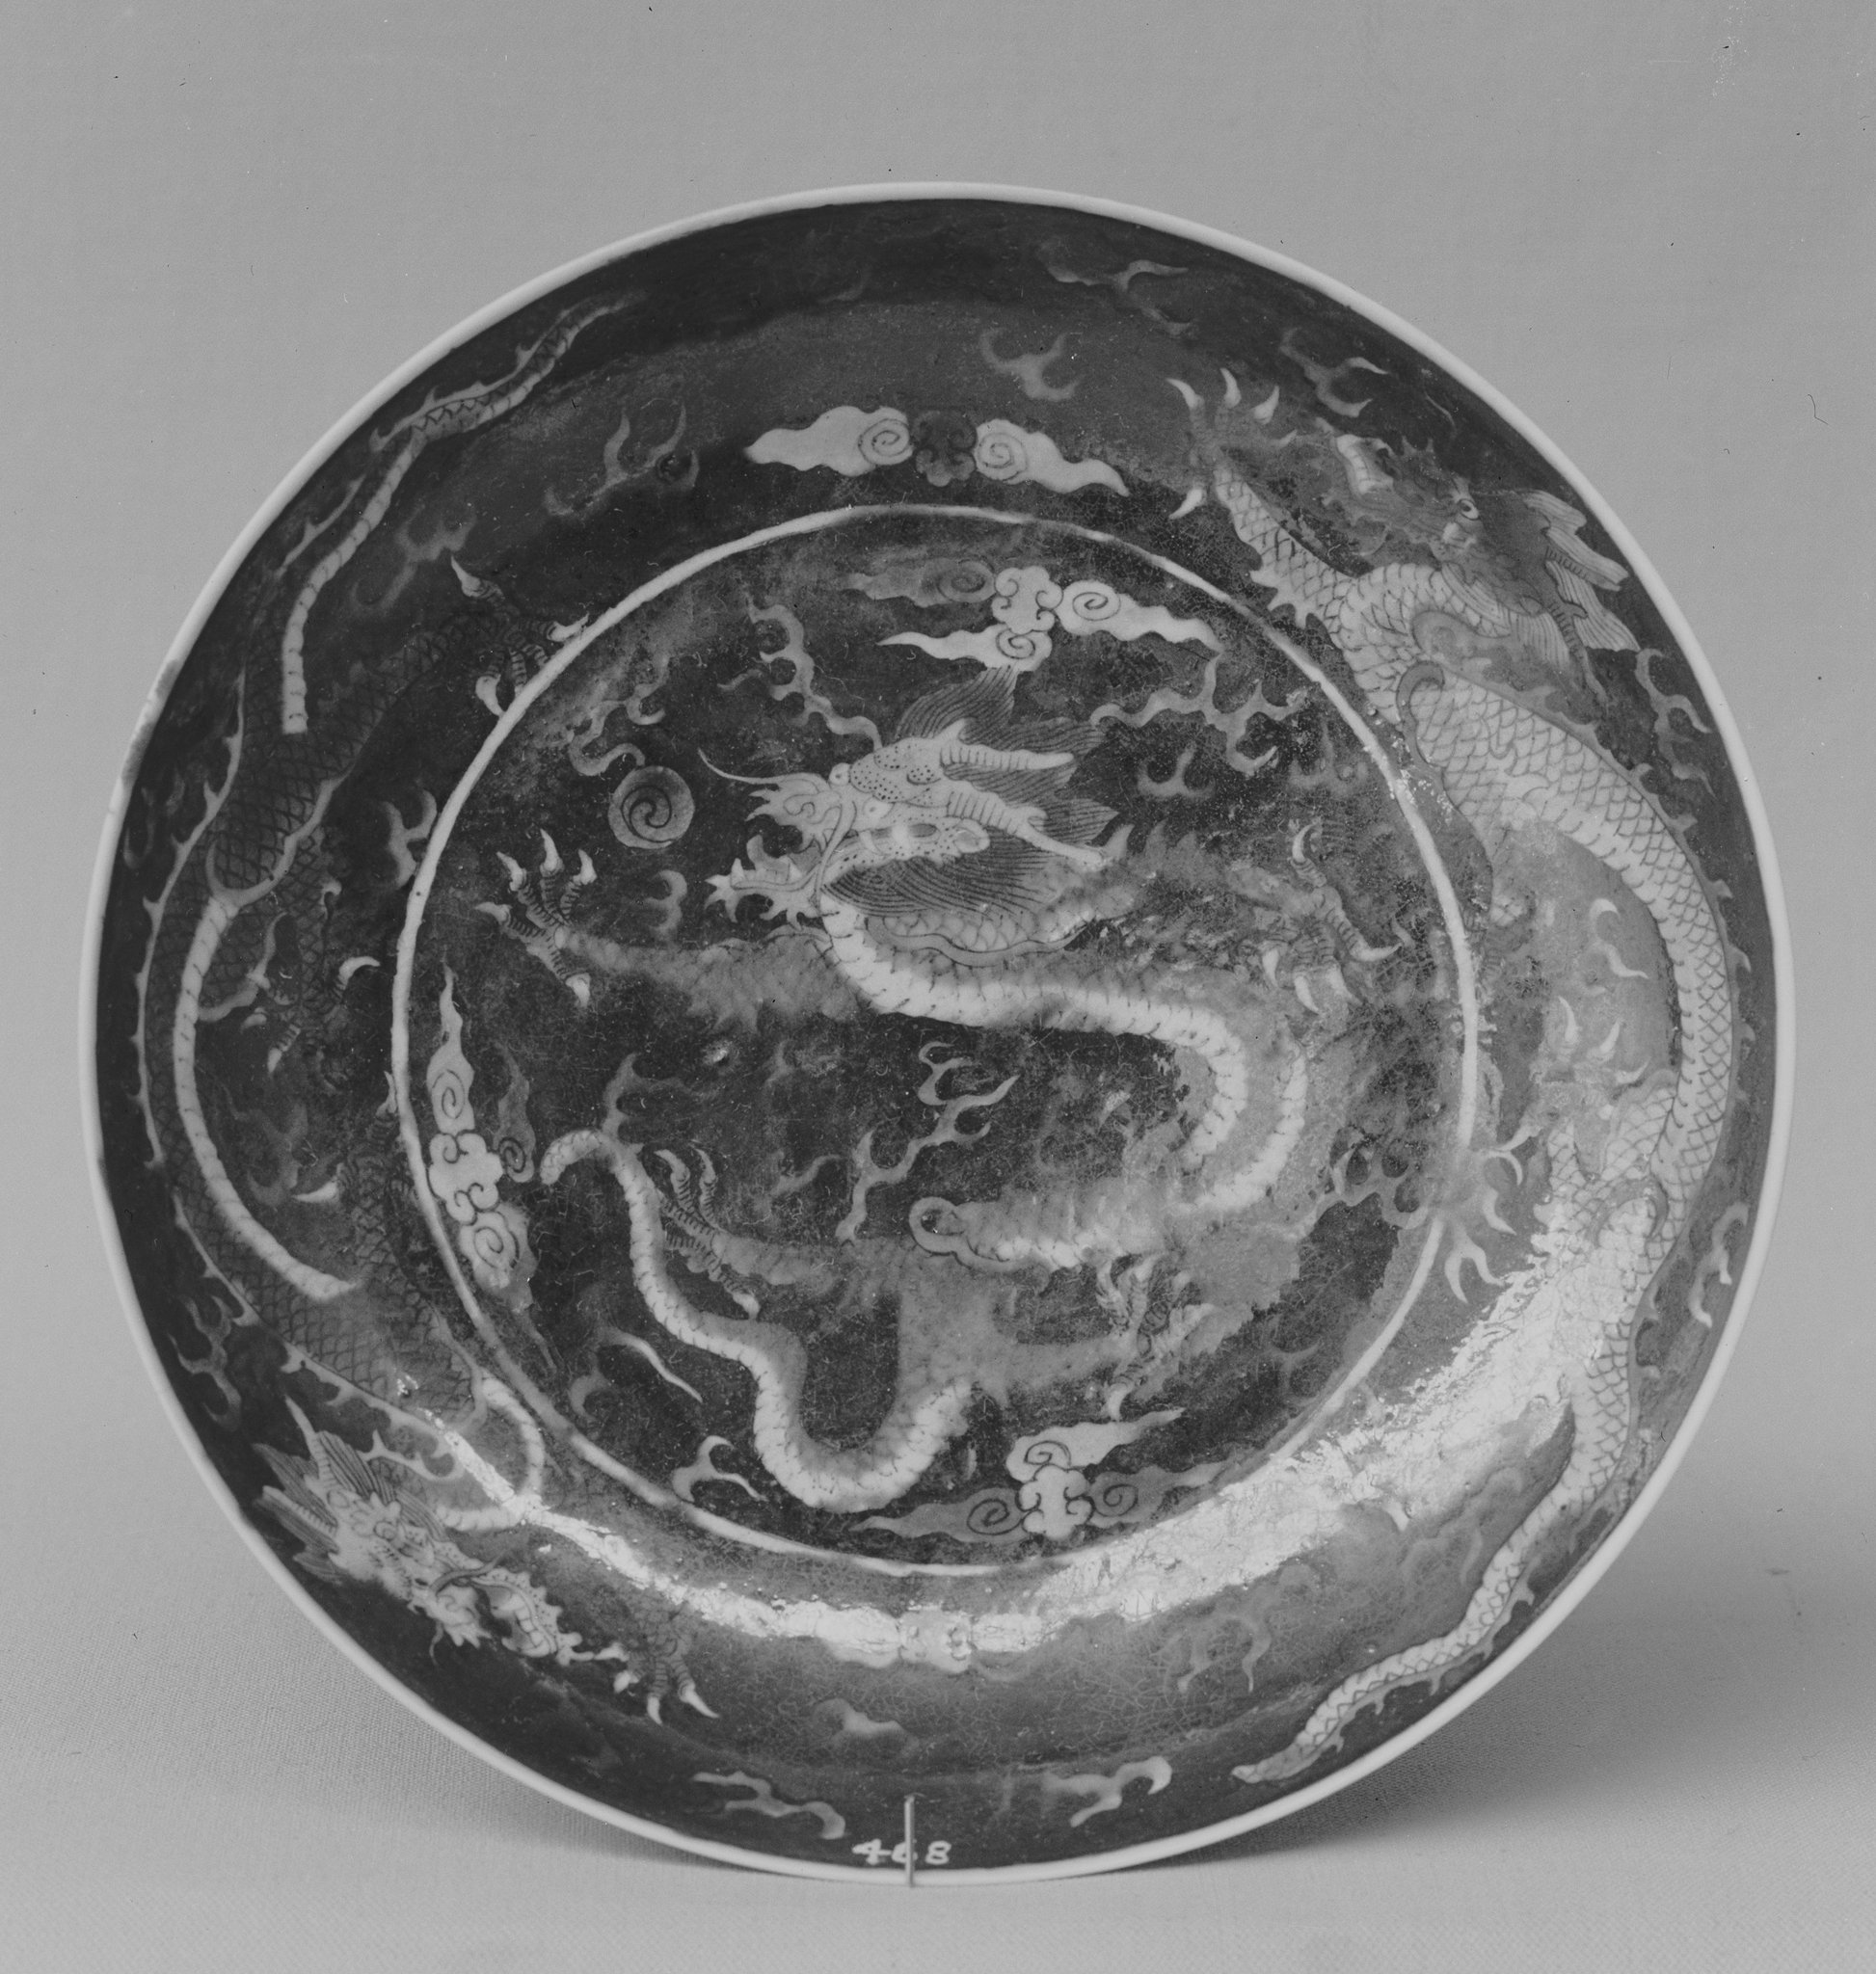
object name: plate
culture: chinese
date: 1900-1999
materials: porcelain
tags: dragons